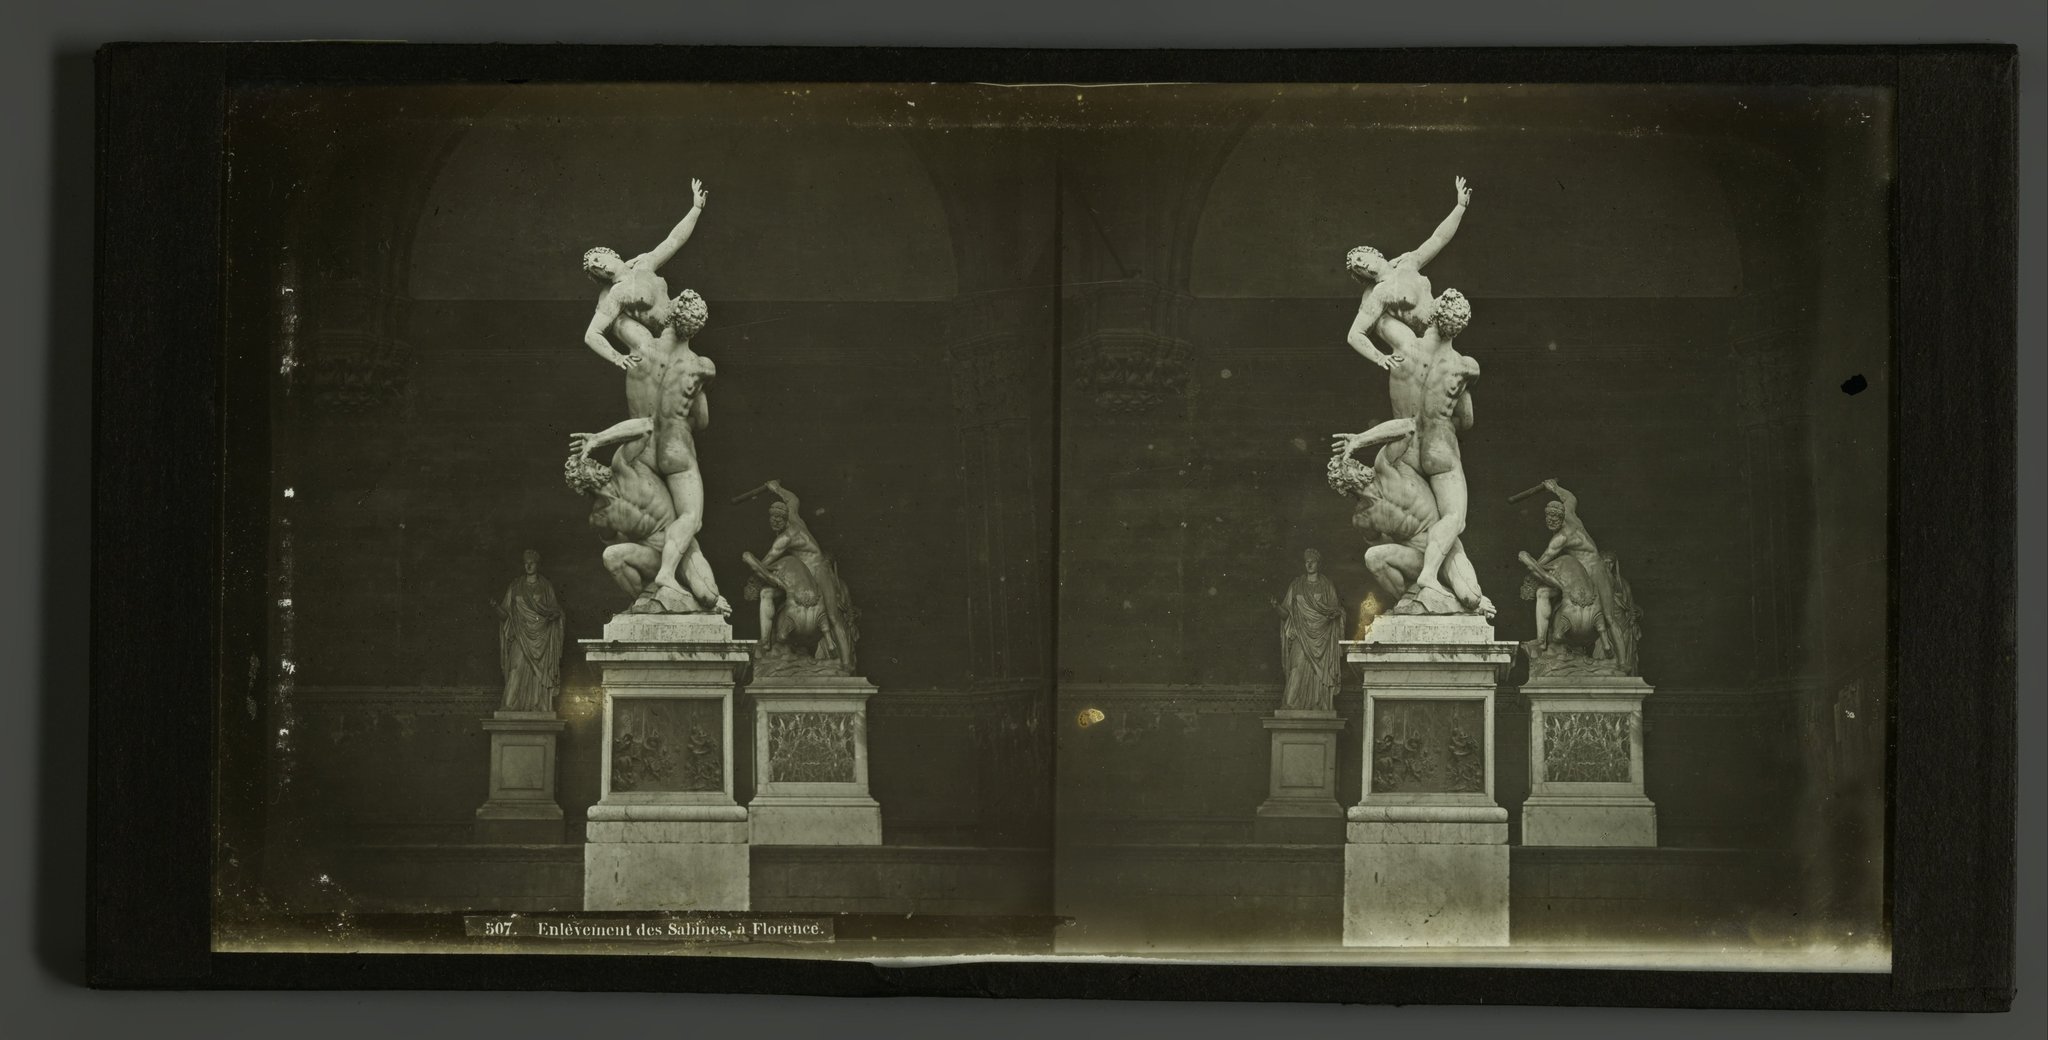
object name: stereoscopic photograph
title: Beeldhouwwerk van de Sabijnse maagdenroof te Florence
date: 1860-1870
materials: glass, paper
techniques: slide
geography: florence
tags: rape of the sabine women: they are carried off by romulus and his men during a feast, sculpture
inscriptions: inscription: ‘507. Enlevement des Sabines, a Florence’